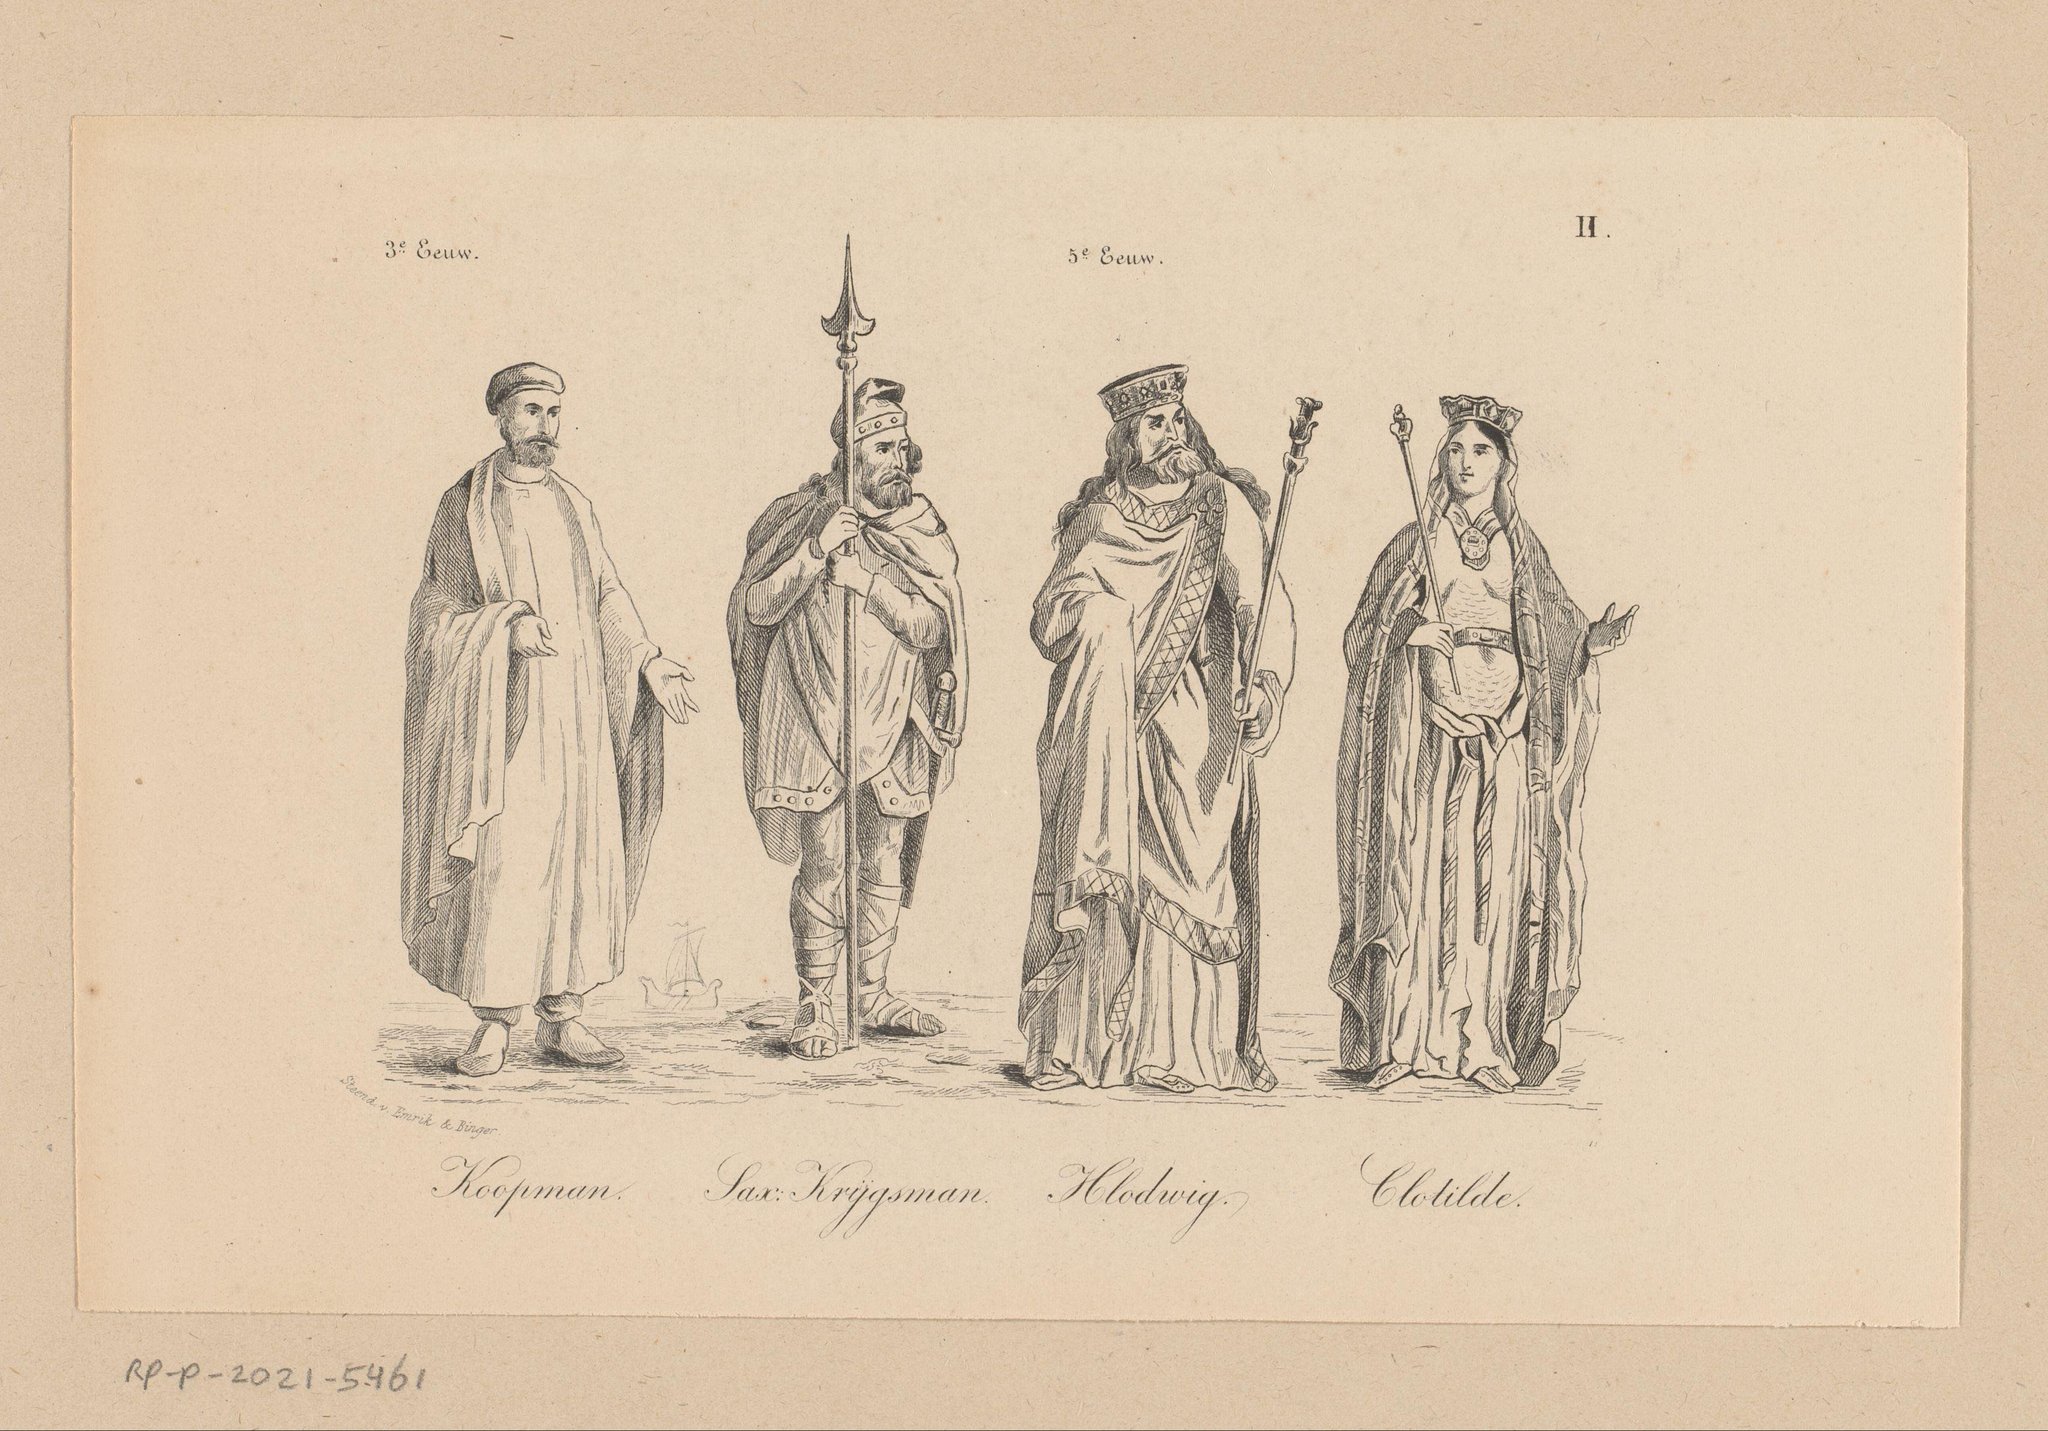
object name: costume print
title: Koopman, krijgsman, Clovis I en Clothilde in kleding uit de derde en vijfde eeuw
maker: Anonymous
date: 1857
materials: paper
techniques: lithograph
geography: netherlands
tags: historical persons - bb - woman, historical persons, clothes, costume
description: Prent waarschijnlijk uit: Hofdijk, Willem Jacob. Schets van de geschiedenis der Nederlanden. Amsterdam: Gebroeders Binger, 1857.